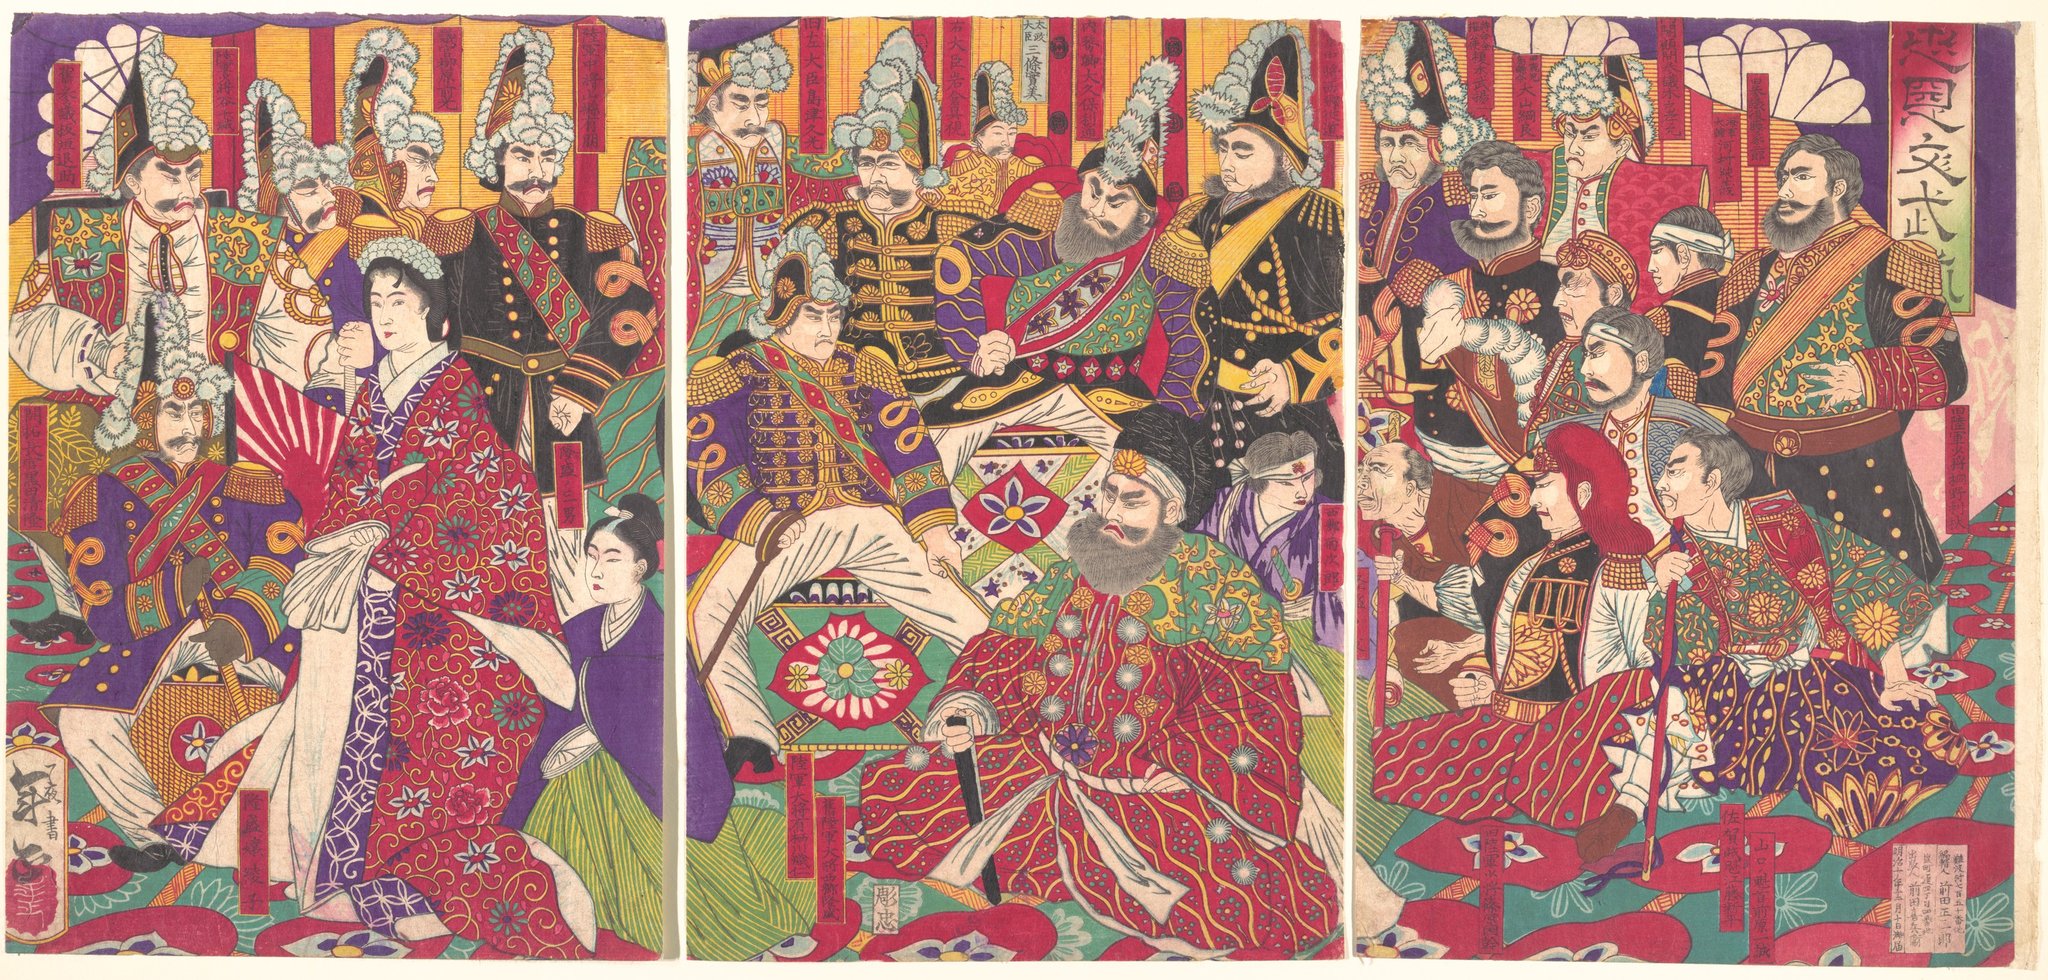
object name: print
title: Civil and Military Officers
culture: japanese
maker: toshimasa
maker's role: artist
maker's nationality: japanese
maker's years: 1801-1900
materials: ink, paper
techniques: woodblock print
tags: soldiers,men,women